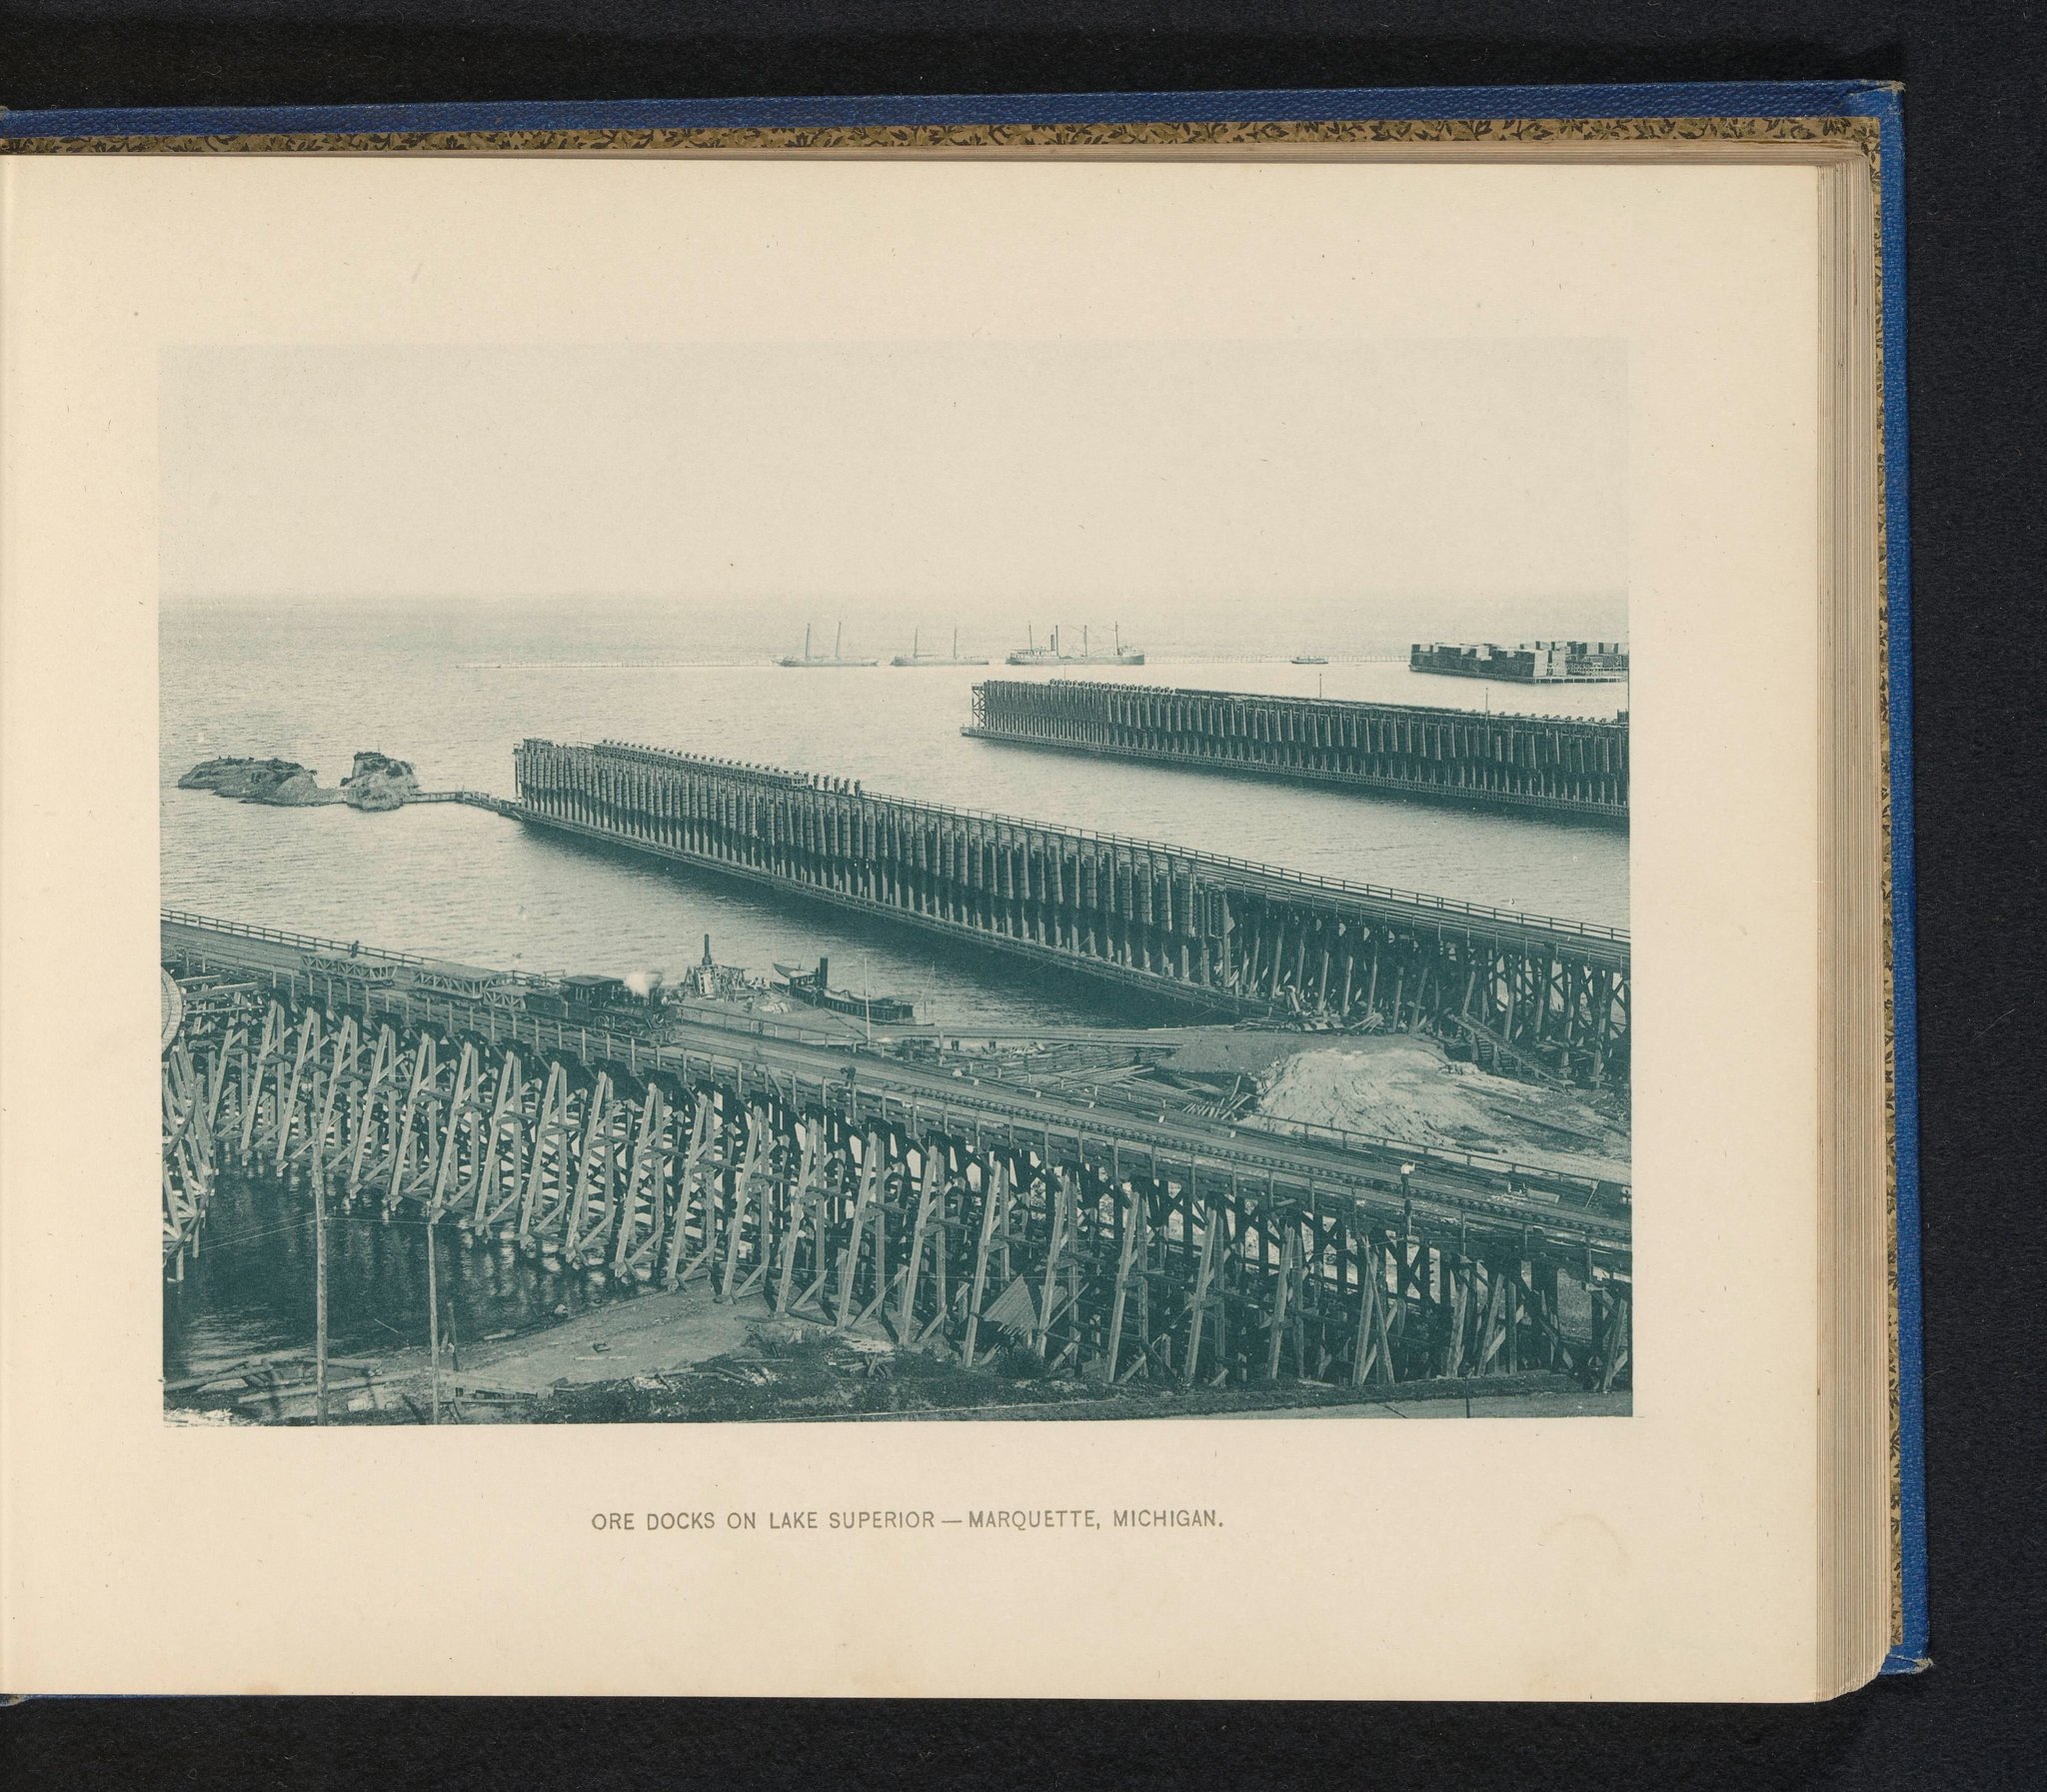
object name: page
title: Gezicht op dokken voor de overslag van ertsen in het Bovenmeer bij Marquette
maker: Anonymous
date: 1883-1893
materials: paper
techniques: photograph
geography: michigan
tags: harbour, lake